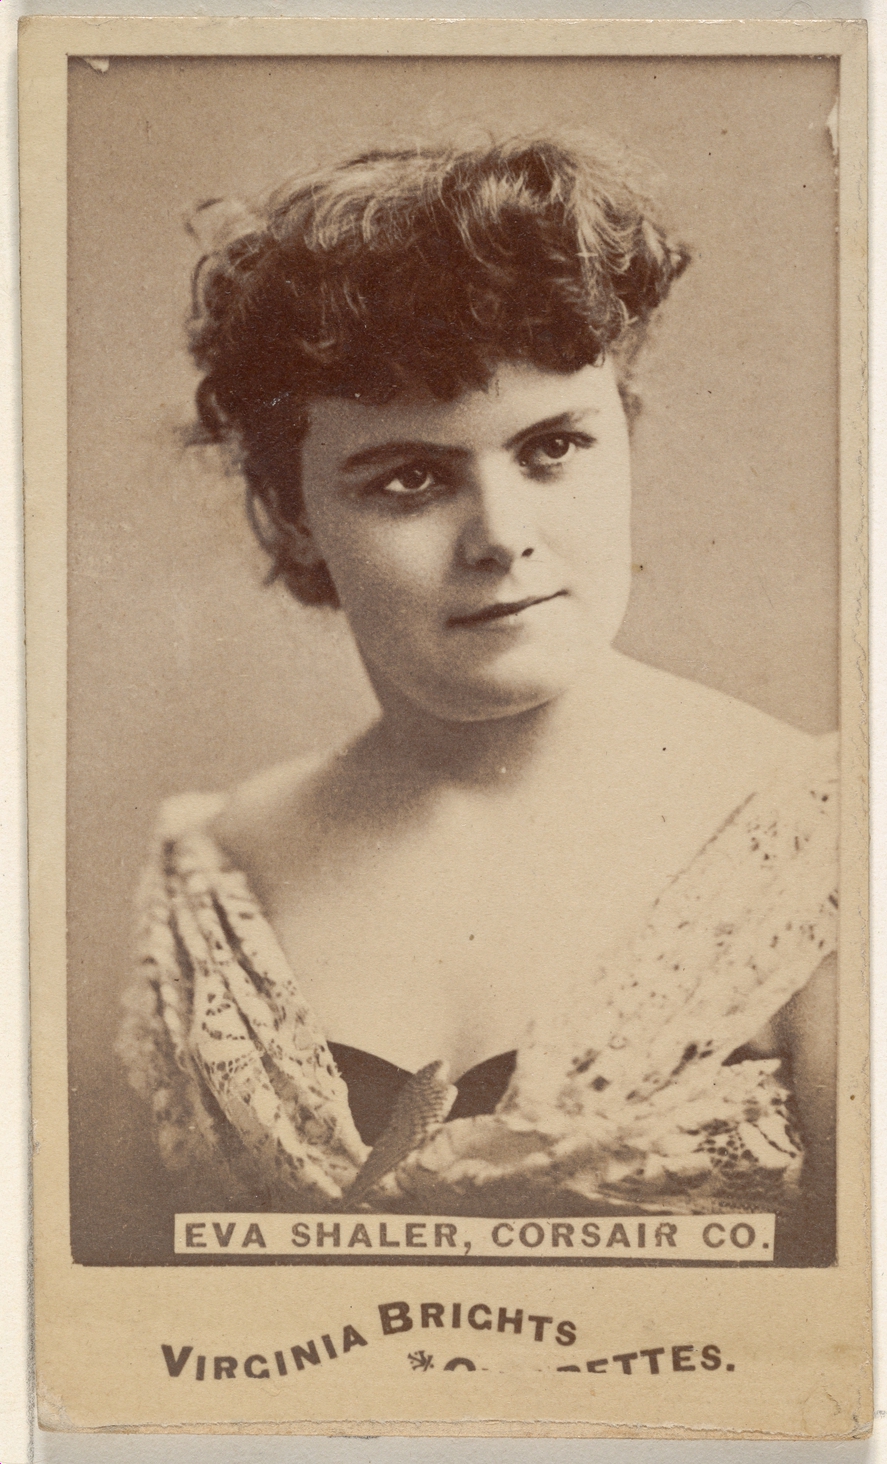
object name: photograph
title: Eva Shaler, Corsair Co., from the Actors and Actresses series (N45, Type 6) for Virginia Brights Cigarettes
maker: allen & ginter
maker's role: publisher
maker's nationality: american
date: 1888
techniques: albumen silver print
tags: portraits,women,actresses